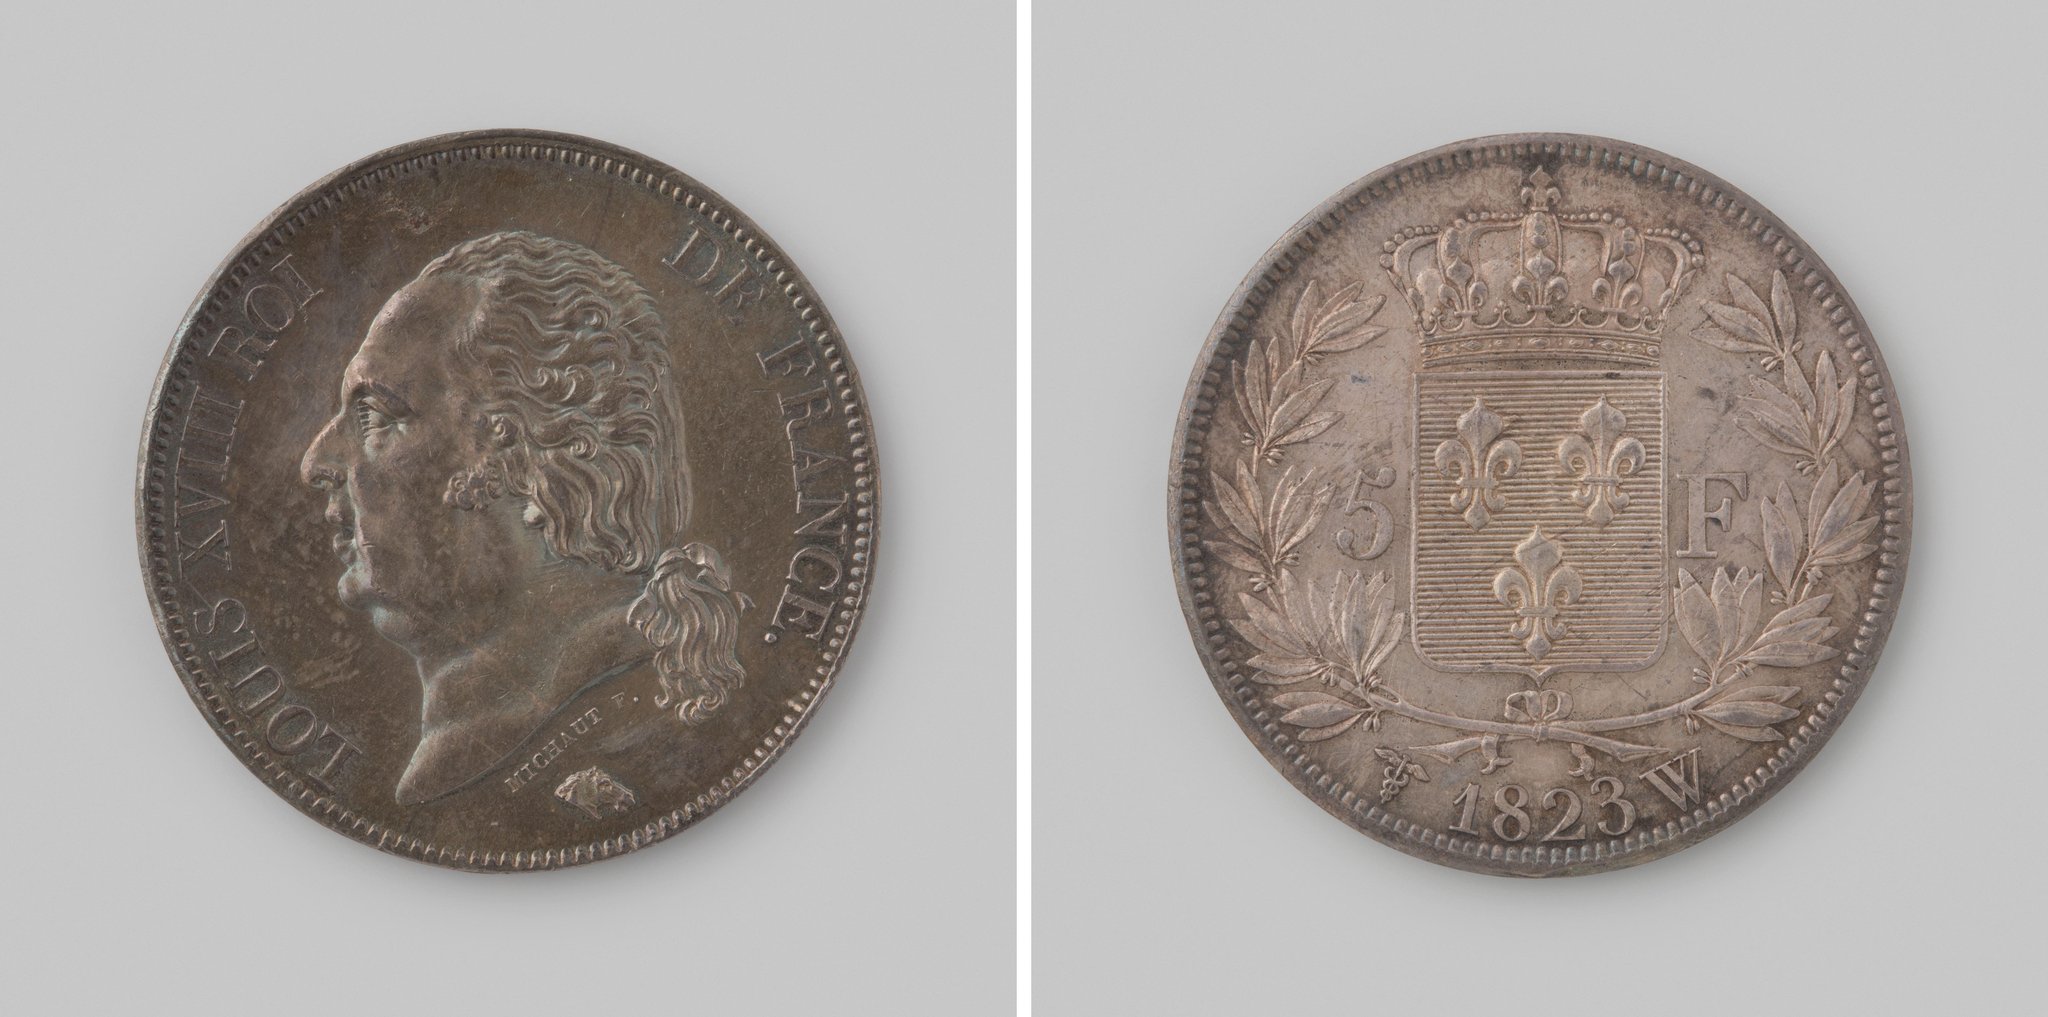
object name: coin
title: Koninkrijk Frankrijk, Lodewijk XVIII, 5 francs, 1823 VV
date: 1823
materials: silver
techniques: striking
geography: lille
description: Zilveren munt. Voorzijde: hoofd van de koning naar links. Keerzijde: binnen twee samengebonden lauriertakken tussen waarde-aanduiding gekroond wapenschild. Onderaan jaartal. Rechts daarvan letters VV [=Lille]. Randschrift.